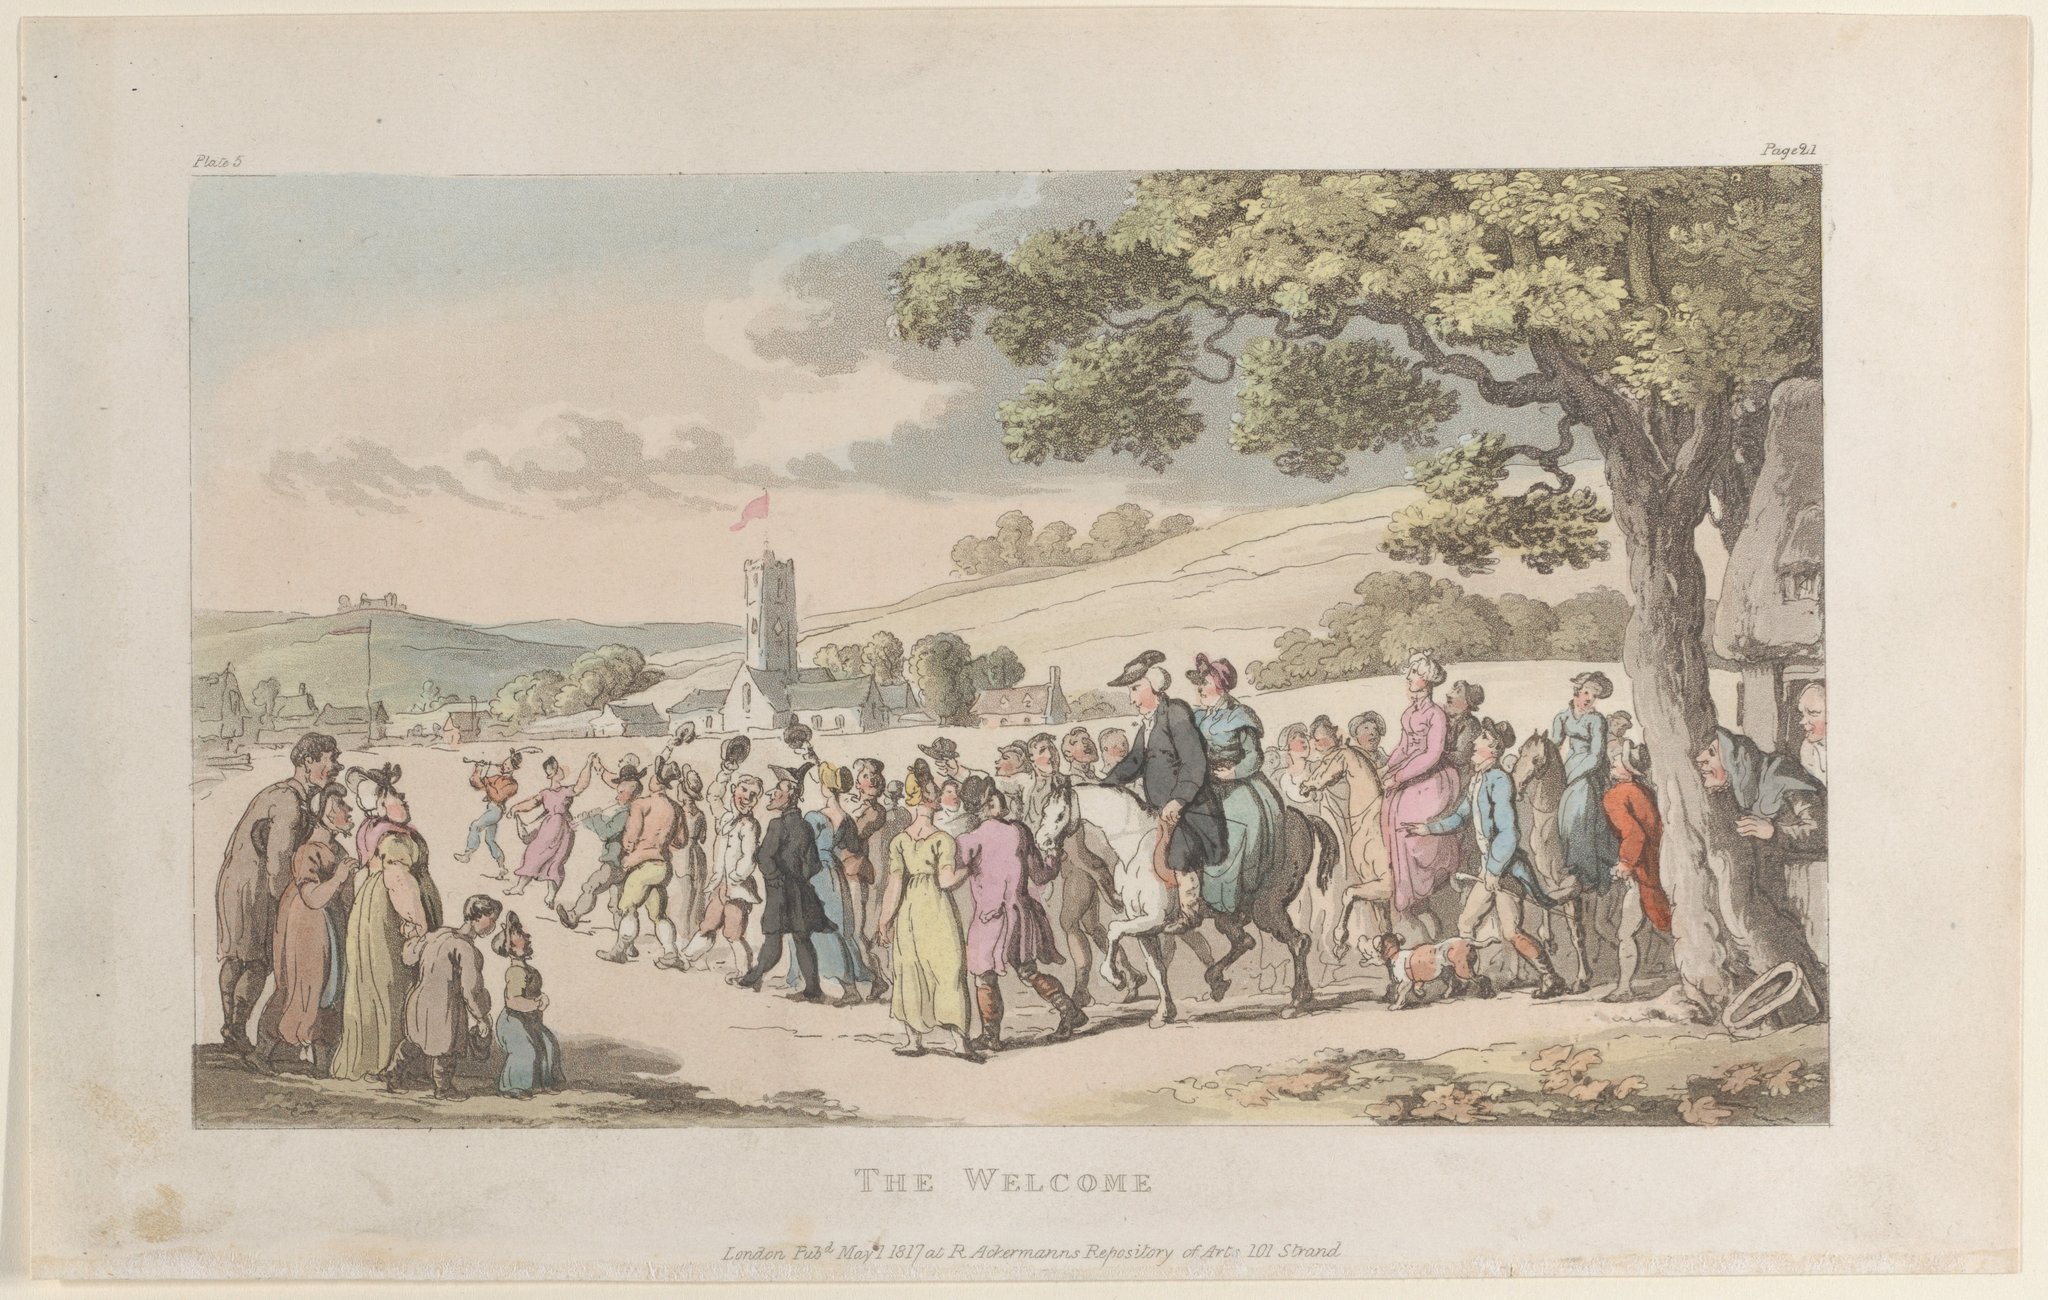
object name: print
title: The Welcome, from "The Vicar of Wakefield"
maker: thomas rowlandson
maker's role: artist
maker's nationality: british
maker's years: 1757-1827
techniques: aquatint, etching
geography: london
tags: men,women,horses